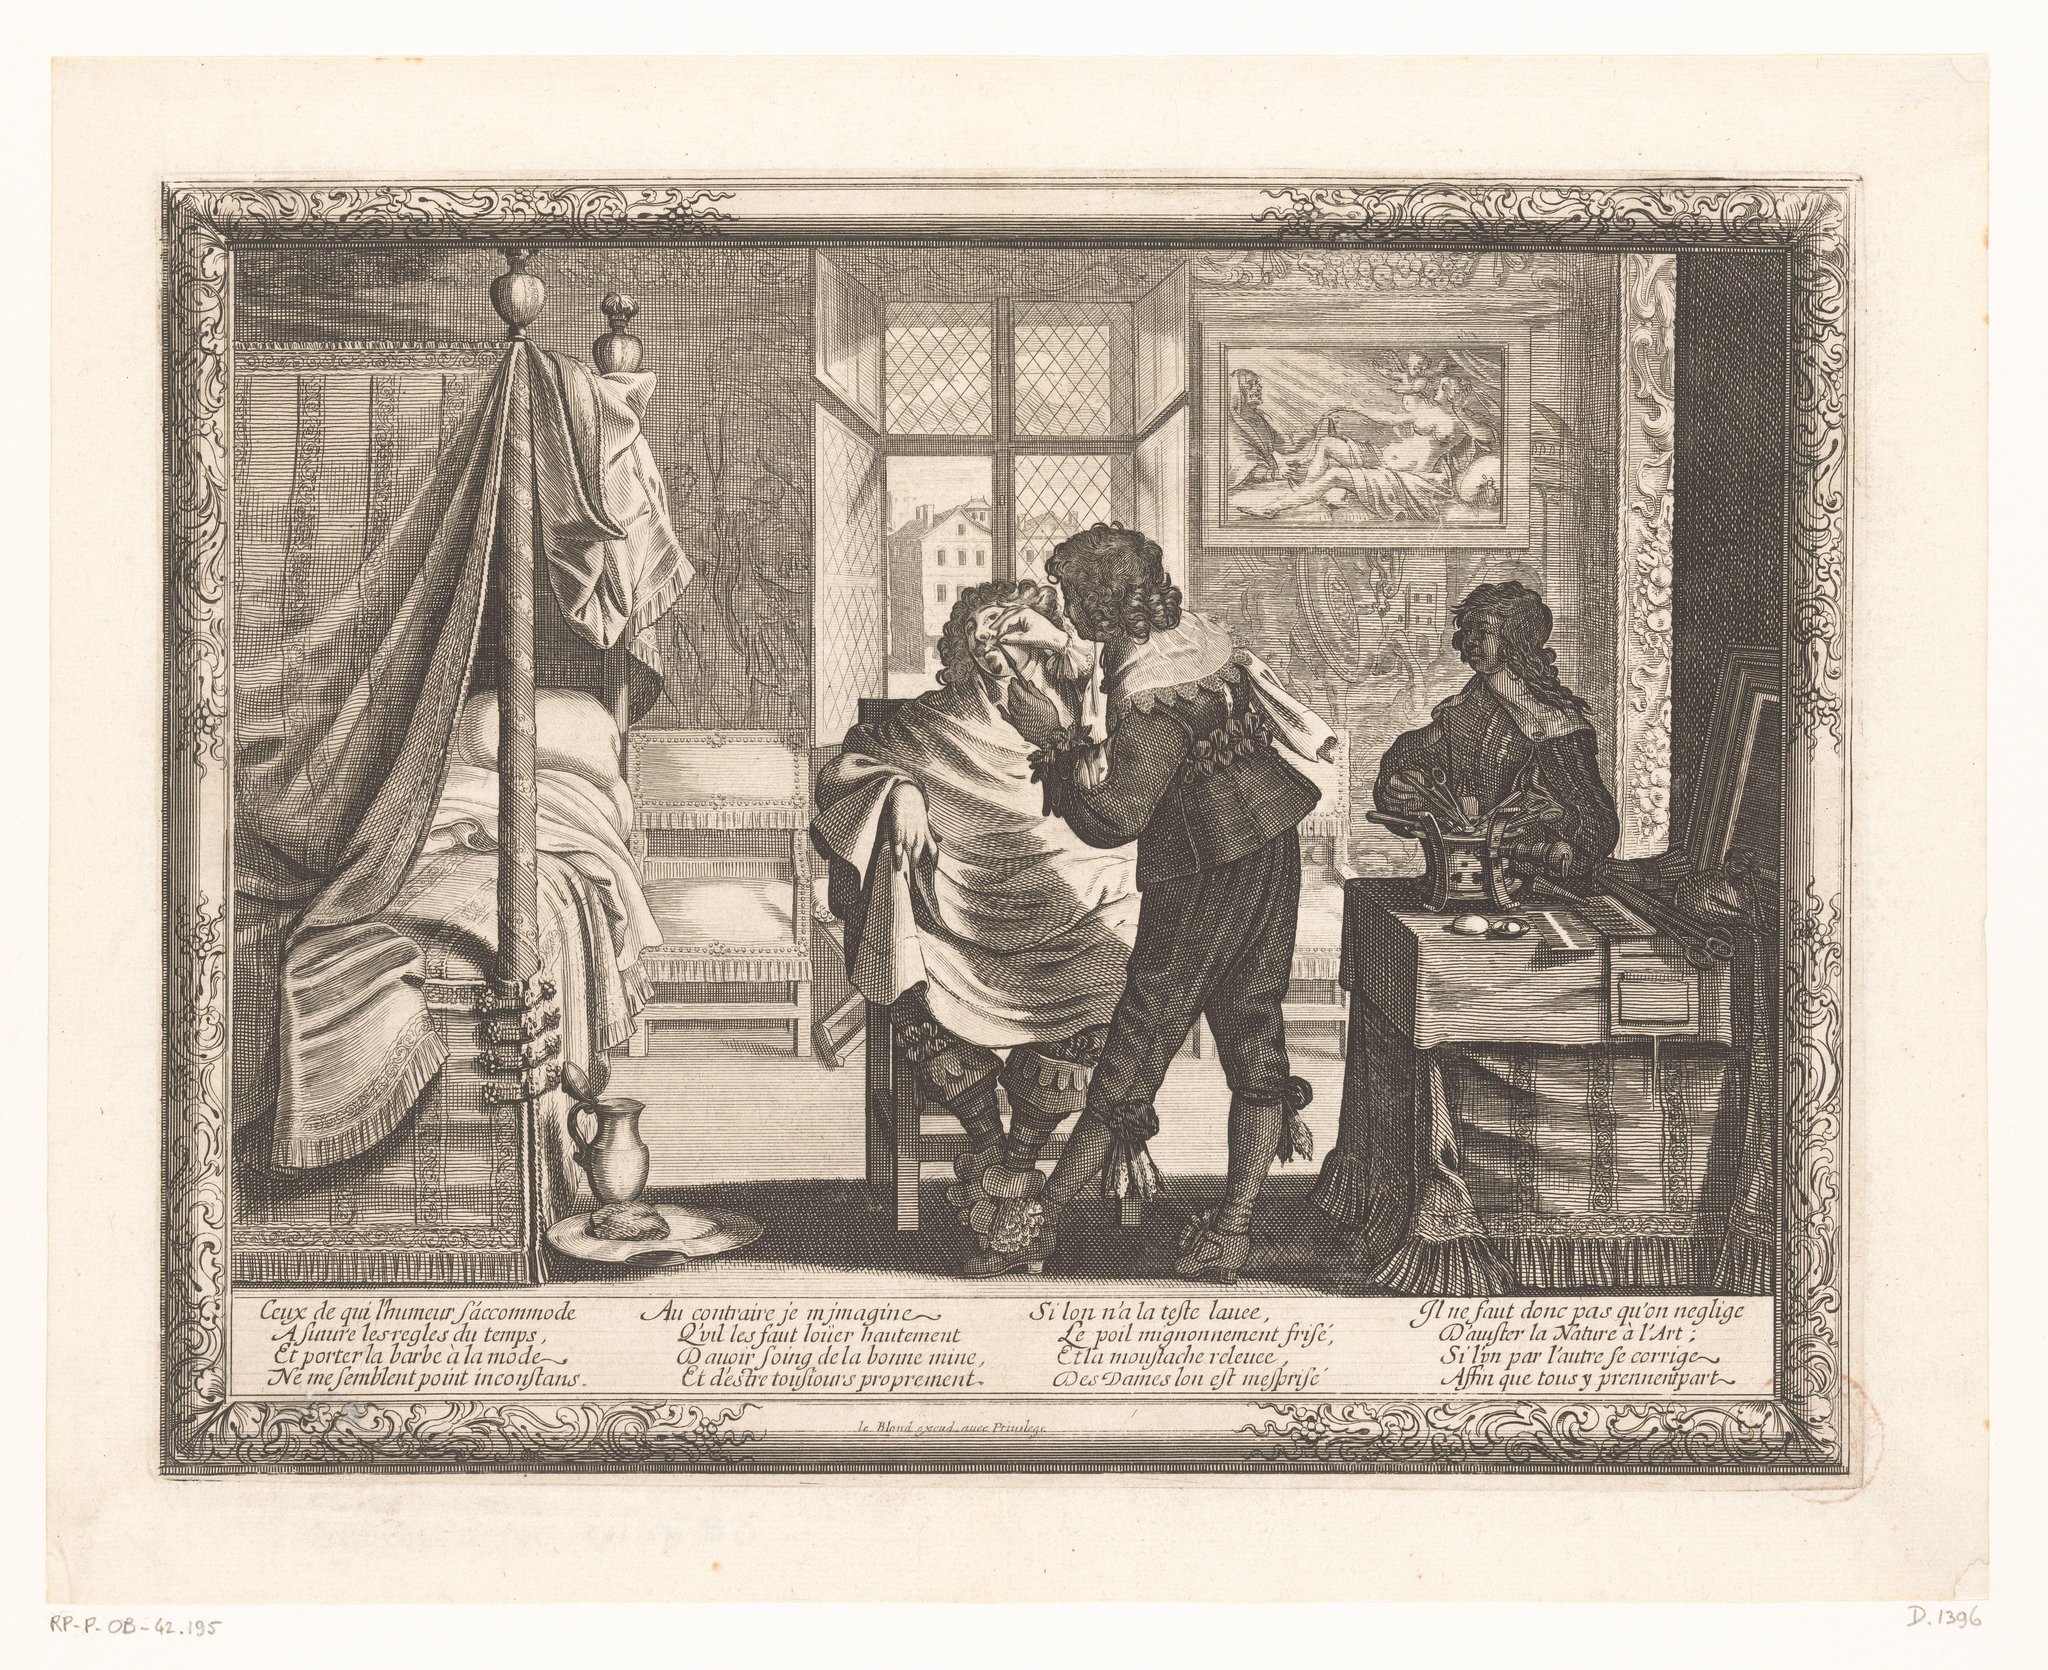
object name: print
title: Les Métiers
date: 1632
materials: paper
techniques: engraving, etching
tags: making toilet, bed with tester, moustache, barber, barbershop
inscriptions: collector's mark: Lugt 240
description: In een slaapvertrek met links een beslapen hemelbed friseert een barbier de snor van een man met behulp van een ijzer. De man zit met een laken om op een stoel. Rechts staat een lakei bij een tafel waarop scharen, kammen en ander kappersgerei. Aan de muren gobelins en een schilderij van Zeus en Danae.